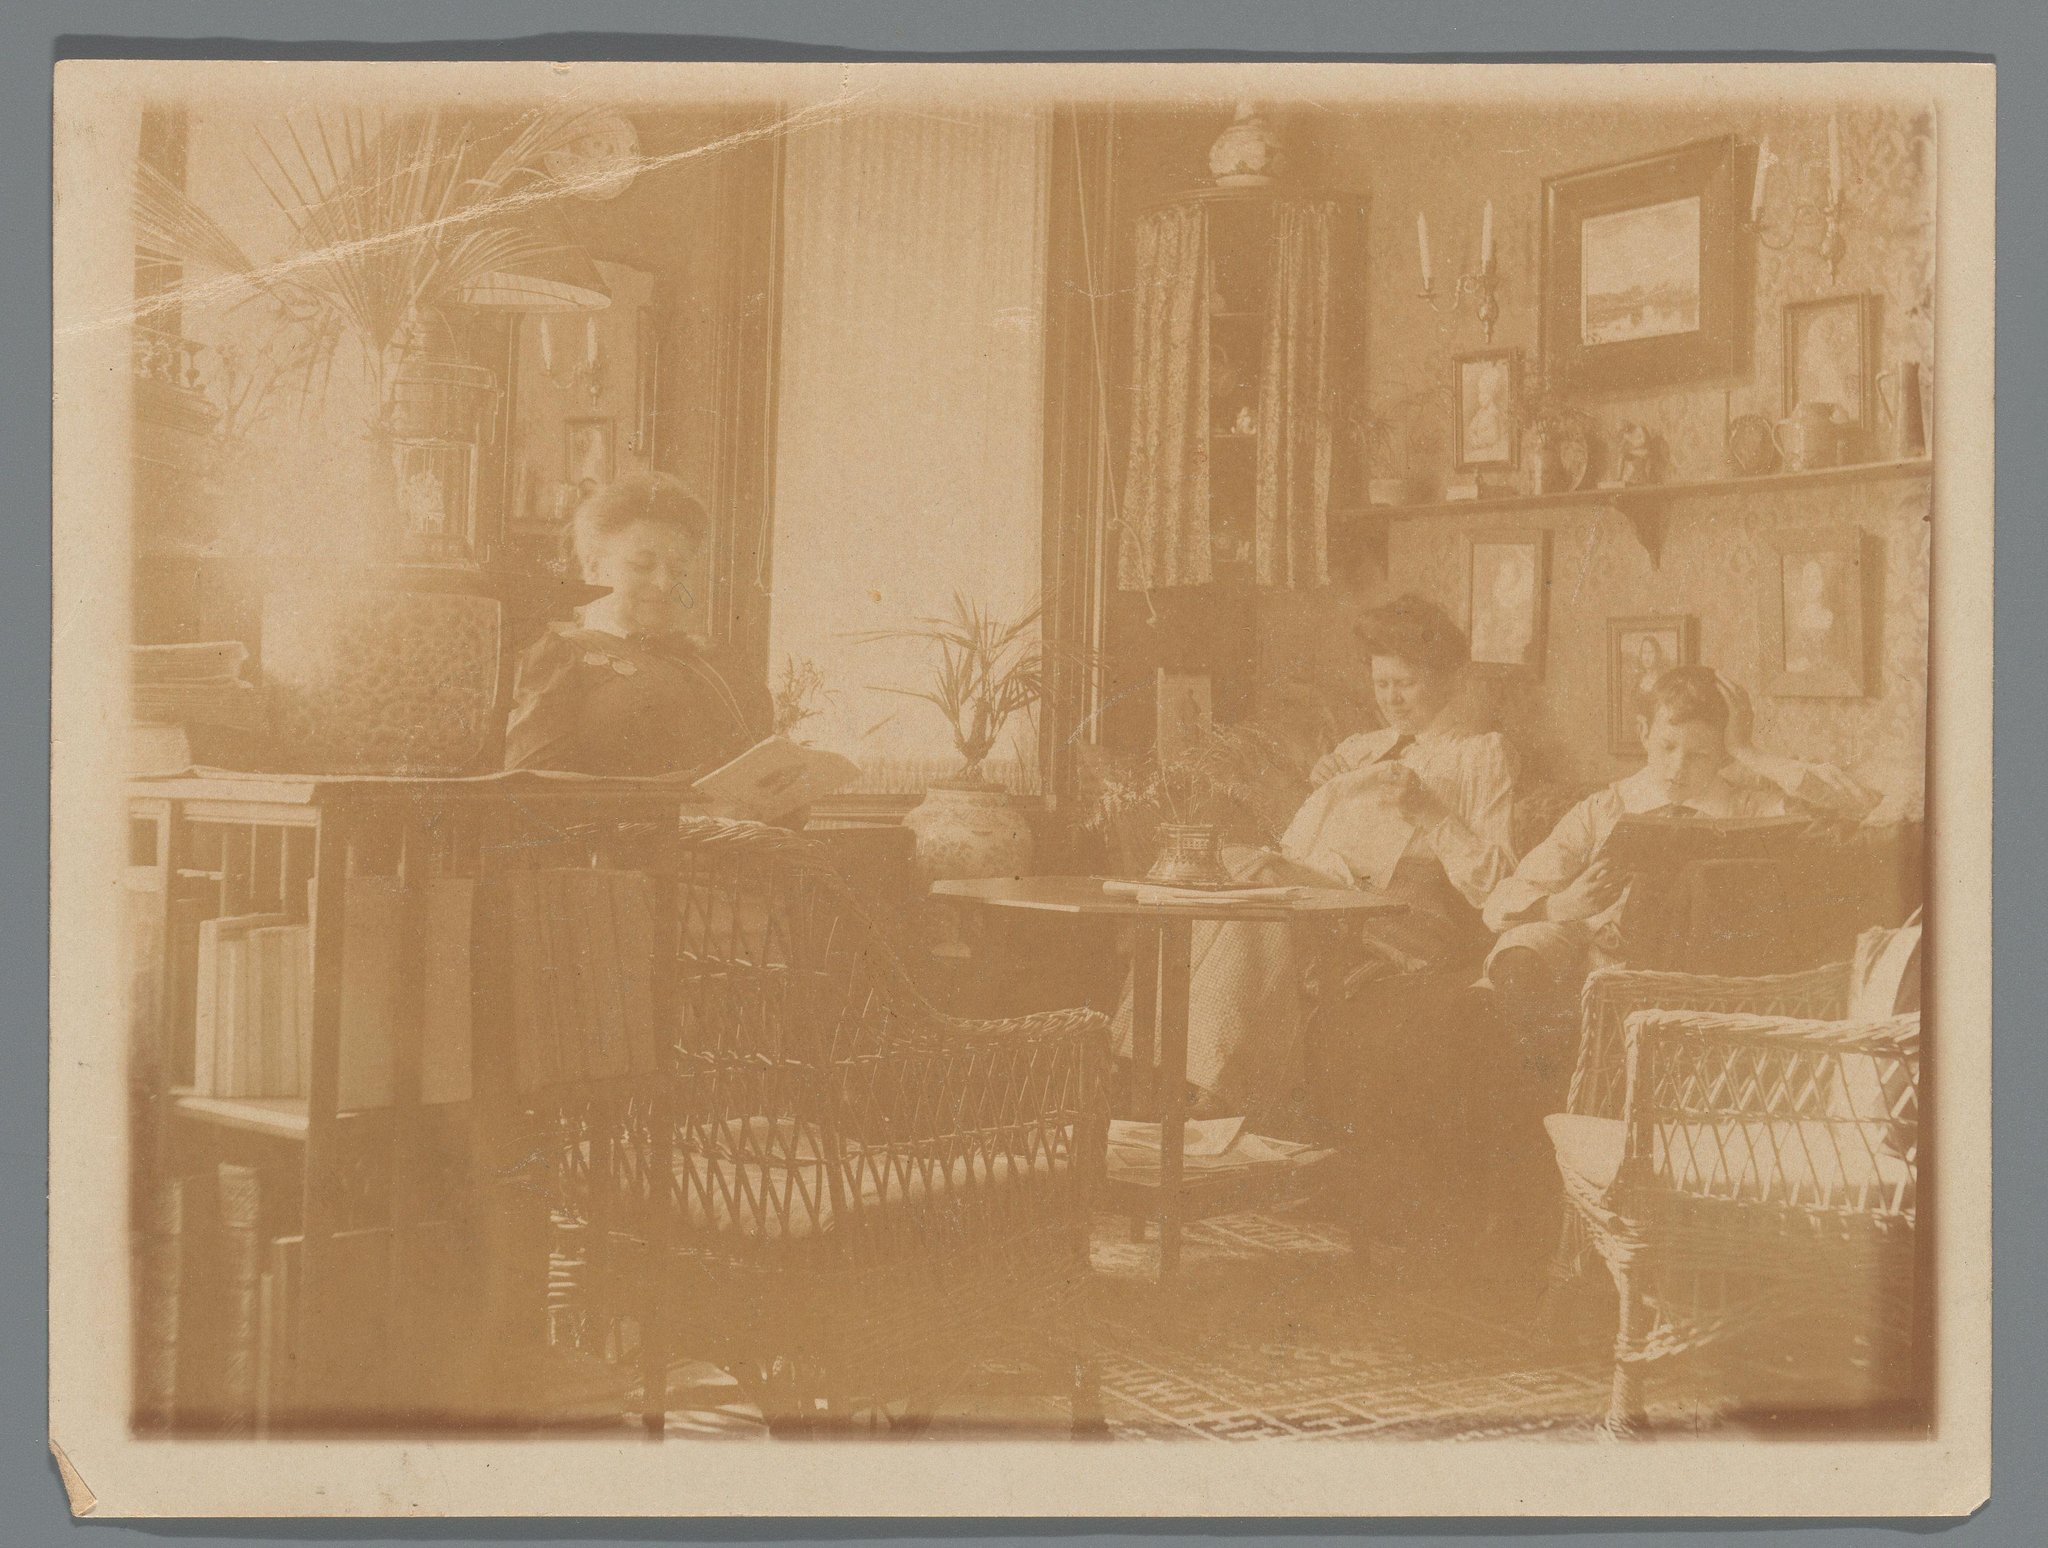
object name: photograph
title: Zitkamer van van Françoise van den Berg met tante Lien en Jan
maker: Anonymous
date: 1902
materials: photographic support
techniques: albumen print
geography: the hague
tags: the hague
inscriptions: inscription: ‘grootmoeder en Jan voor Lien in / Zitkamer Van Moeder / en tante Leo. / Waldeck Pyrmontkade / den Haag’